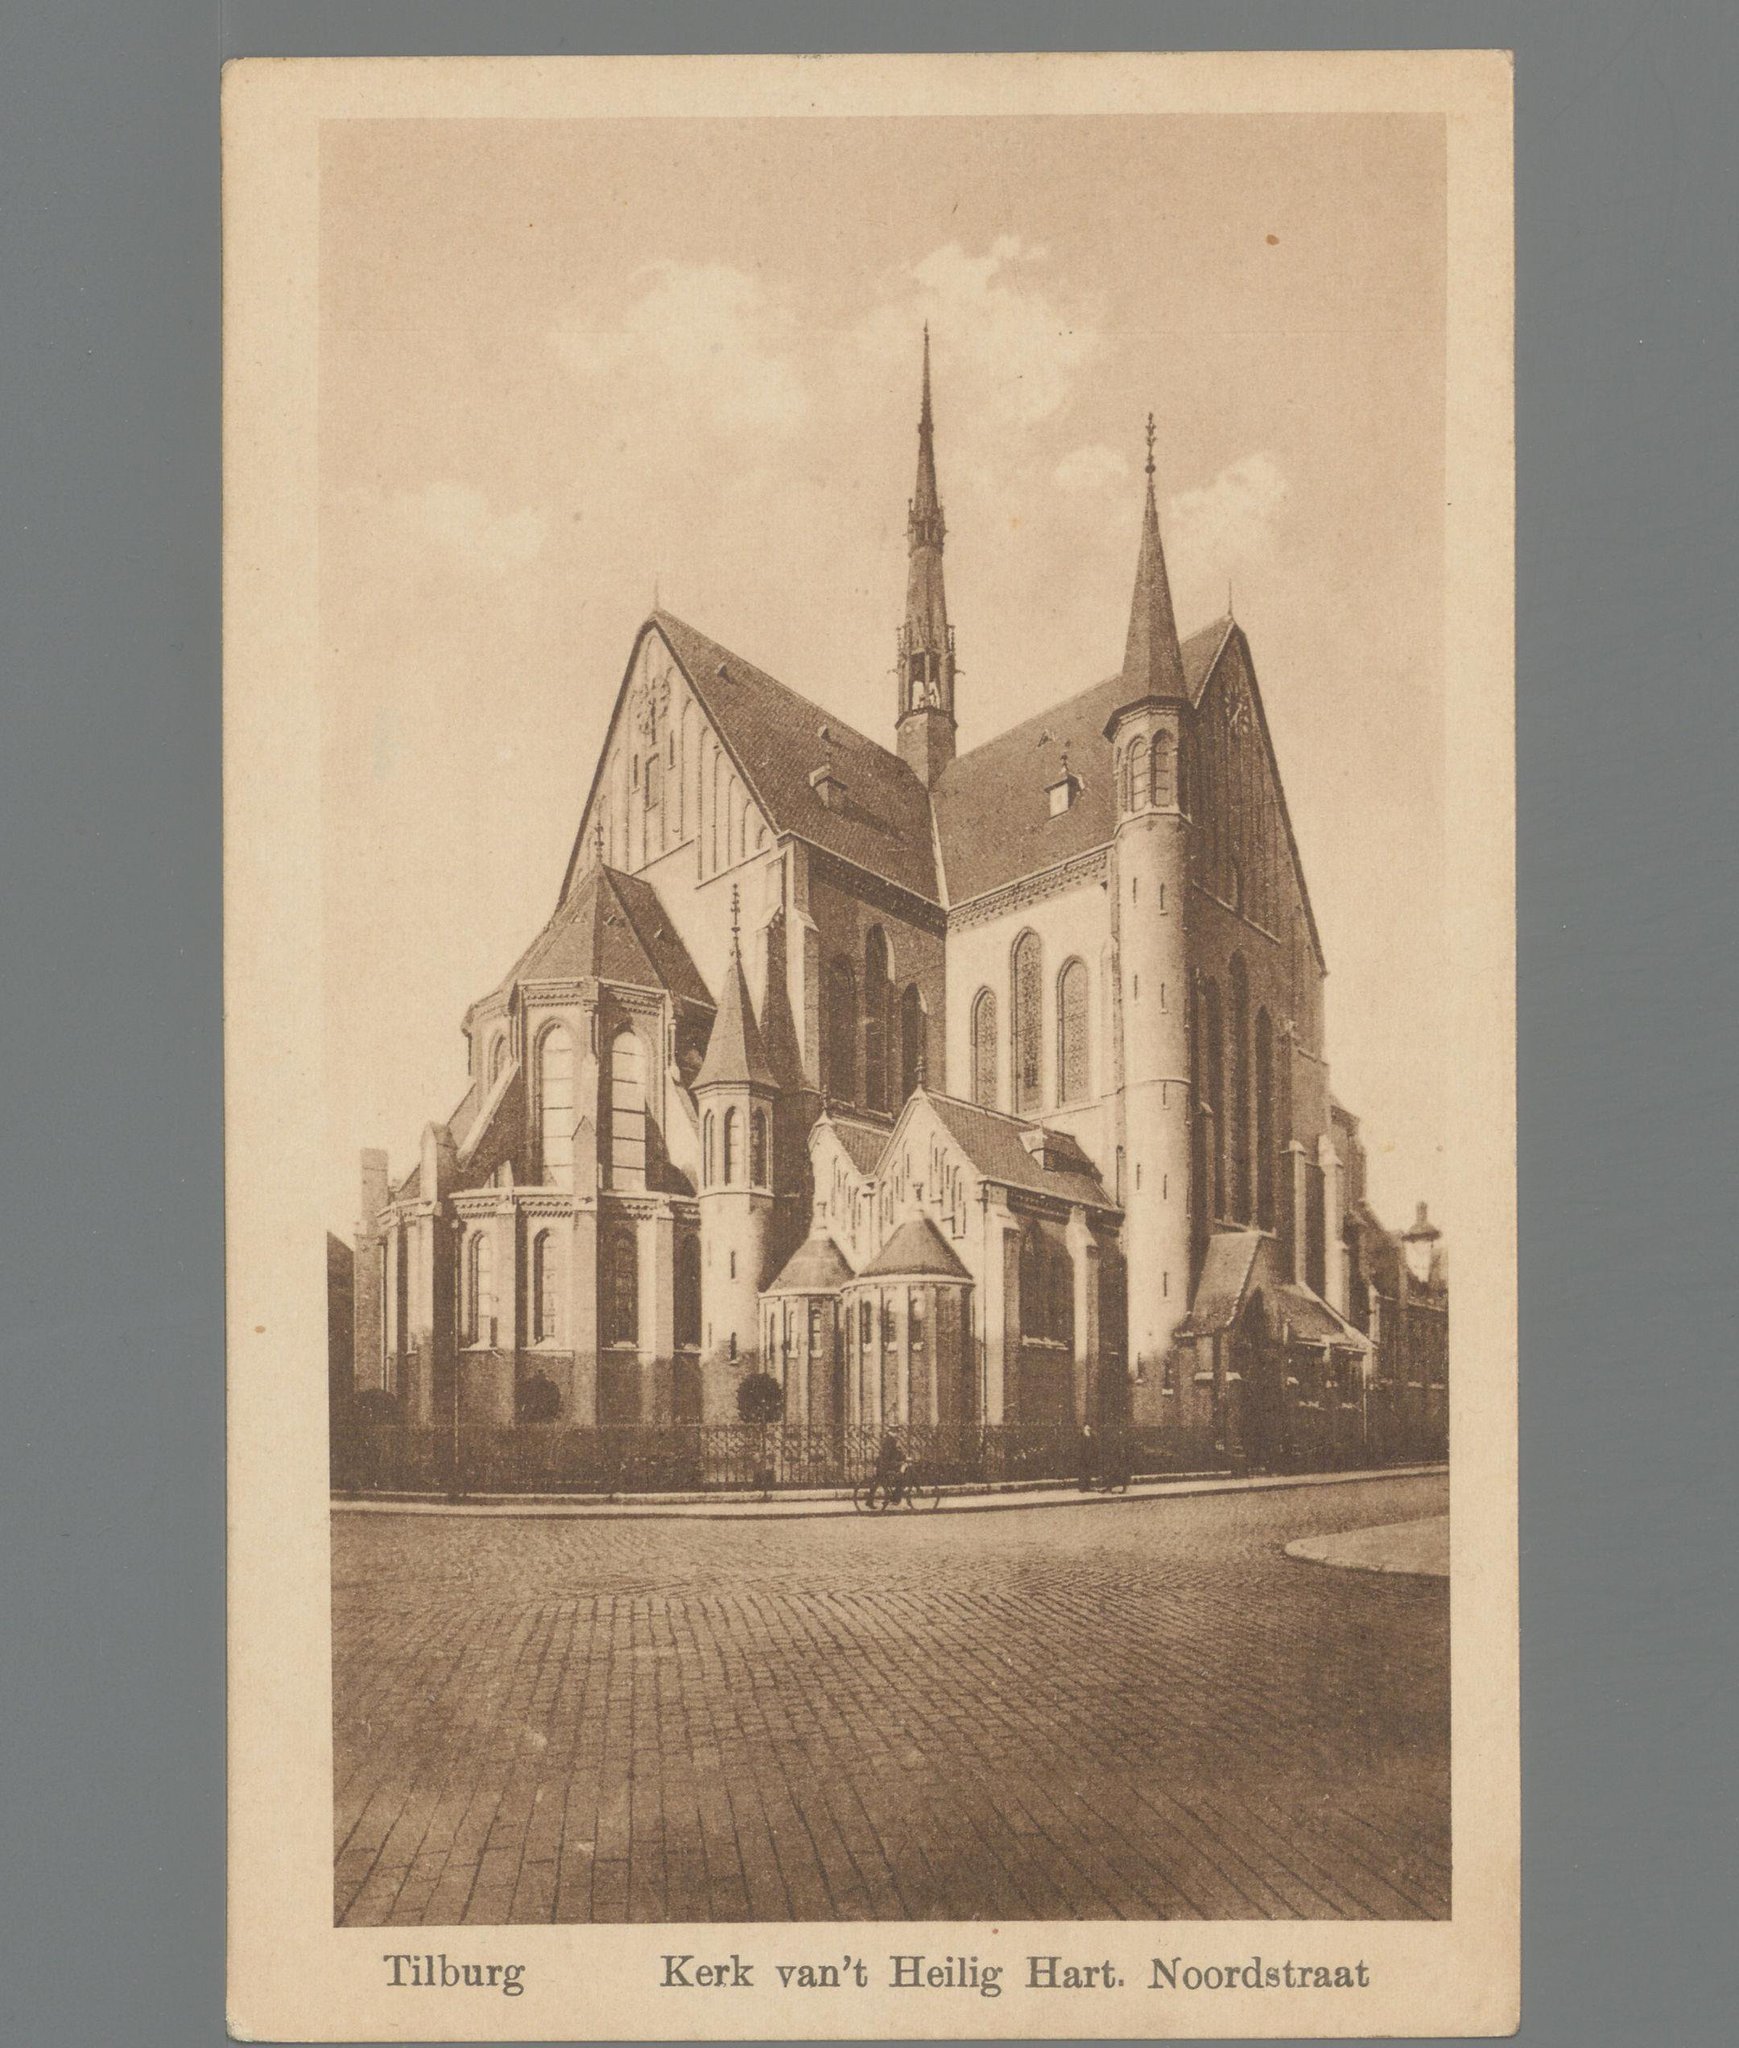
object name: photomechanical print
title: Tilburg. Kerk van't Heilig Hart. Noordstraat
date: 1913-1926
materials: cardboard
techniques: photograph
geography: amsterdam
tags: church (exterior)